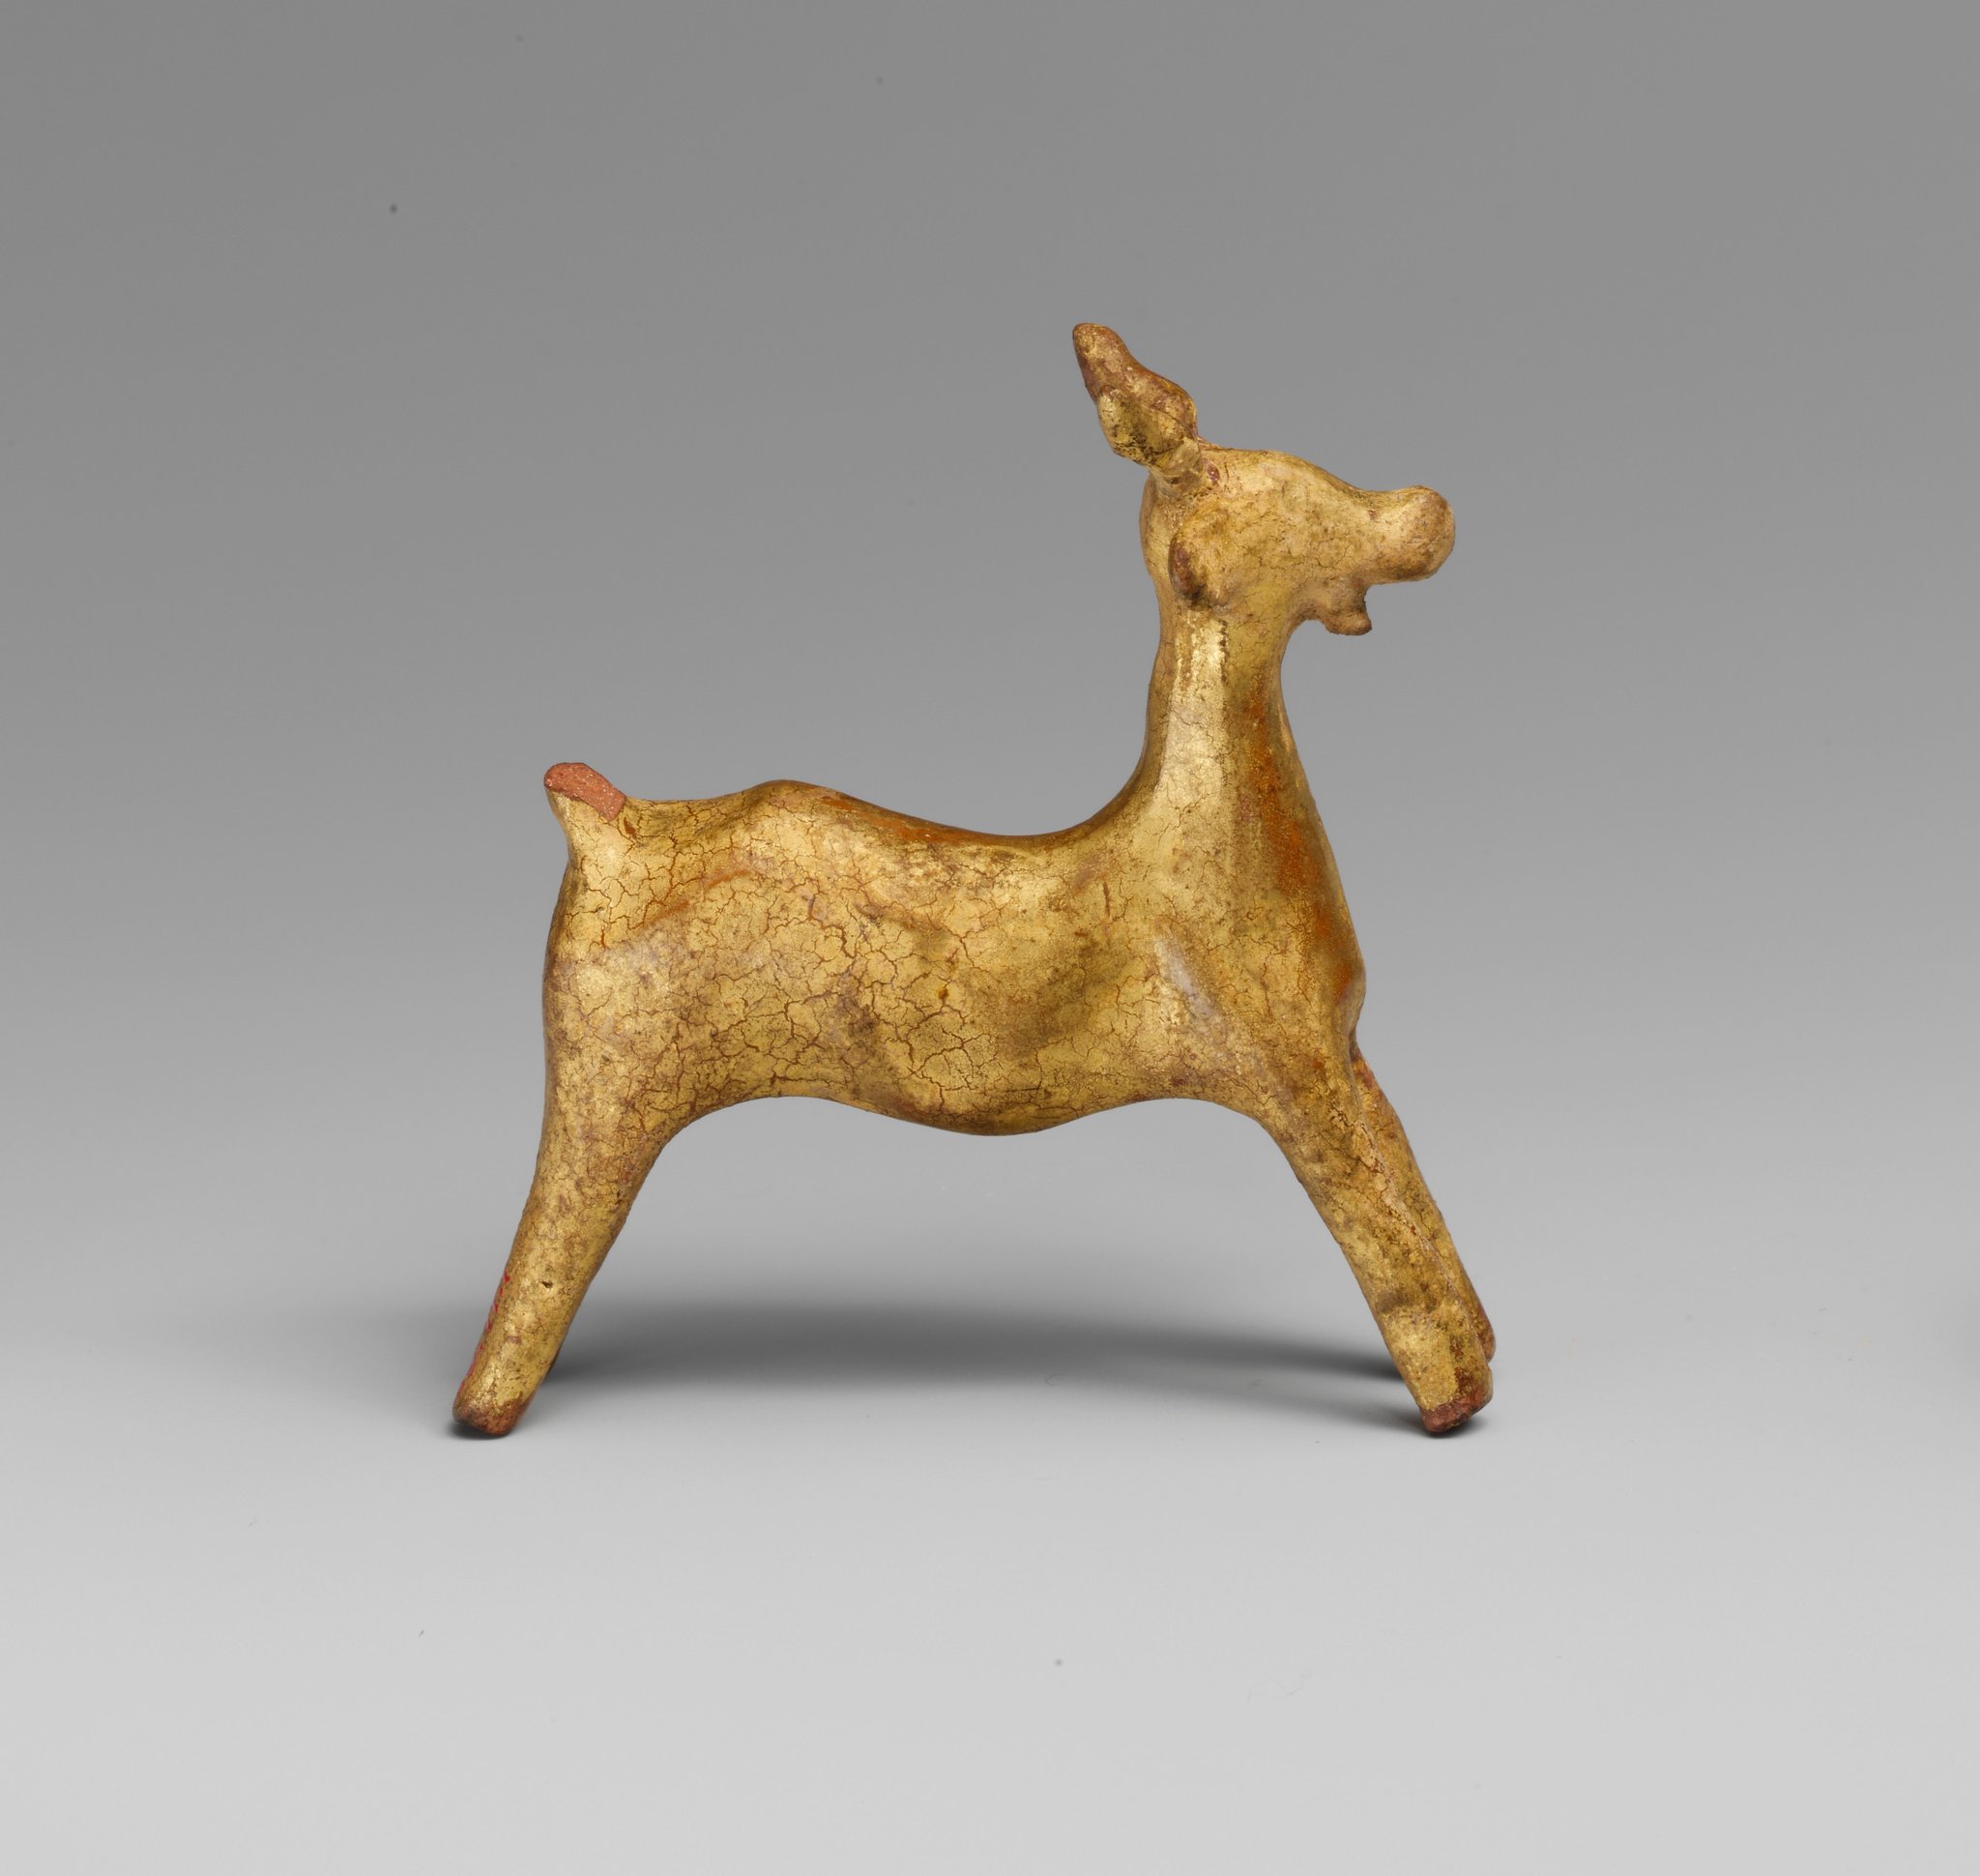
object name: statuette of a goat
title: Gilt terracotta statuette of a goat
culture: mycenaean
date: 1400-1301 BCE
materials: gold, terracotta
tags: goats